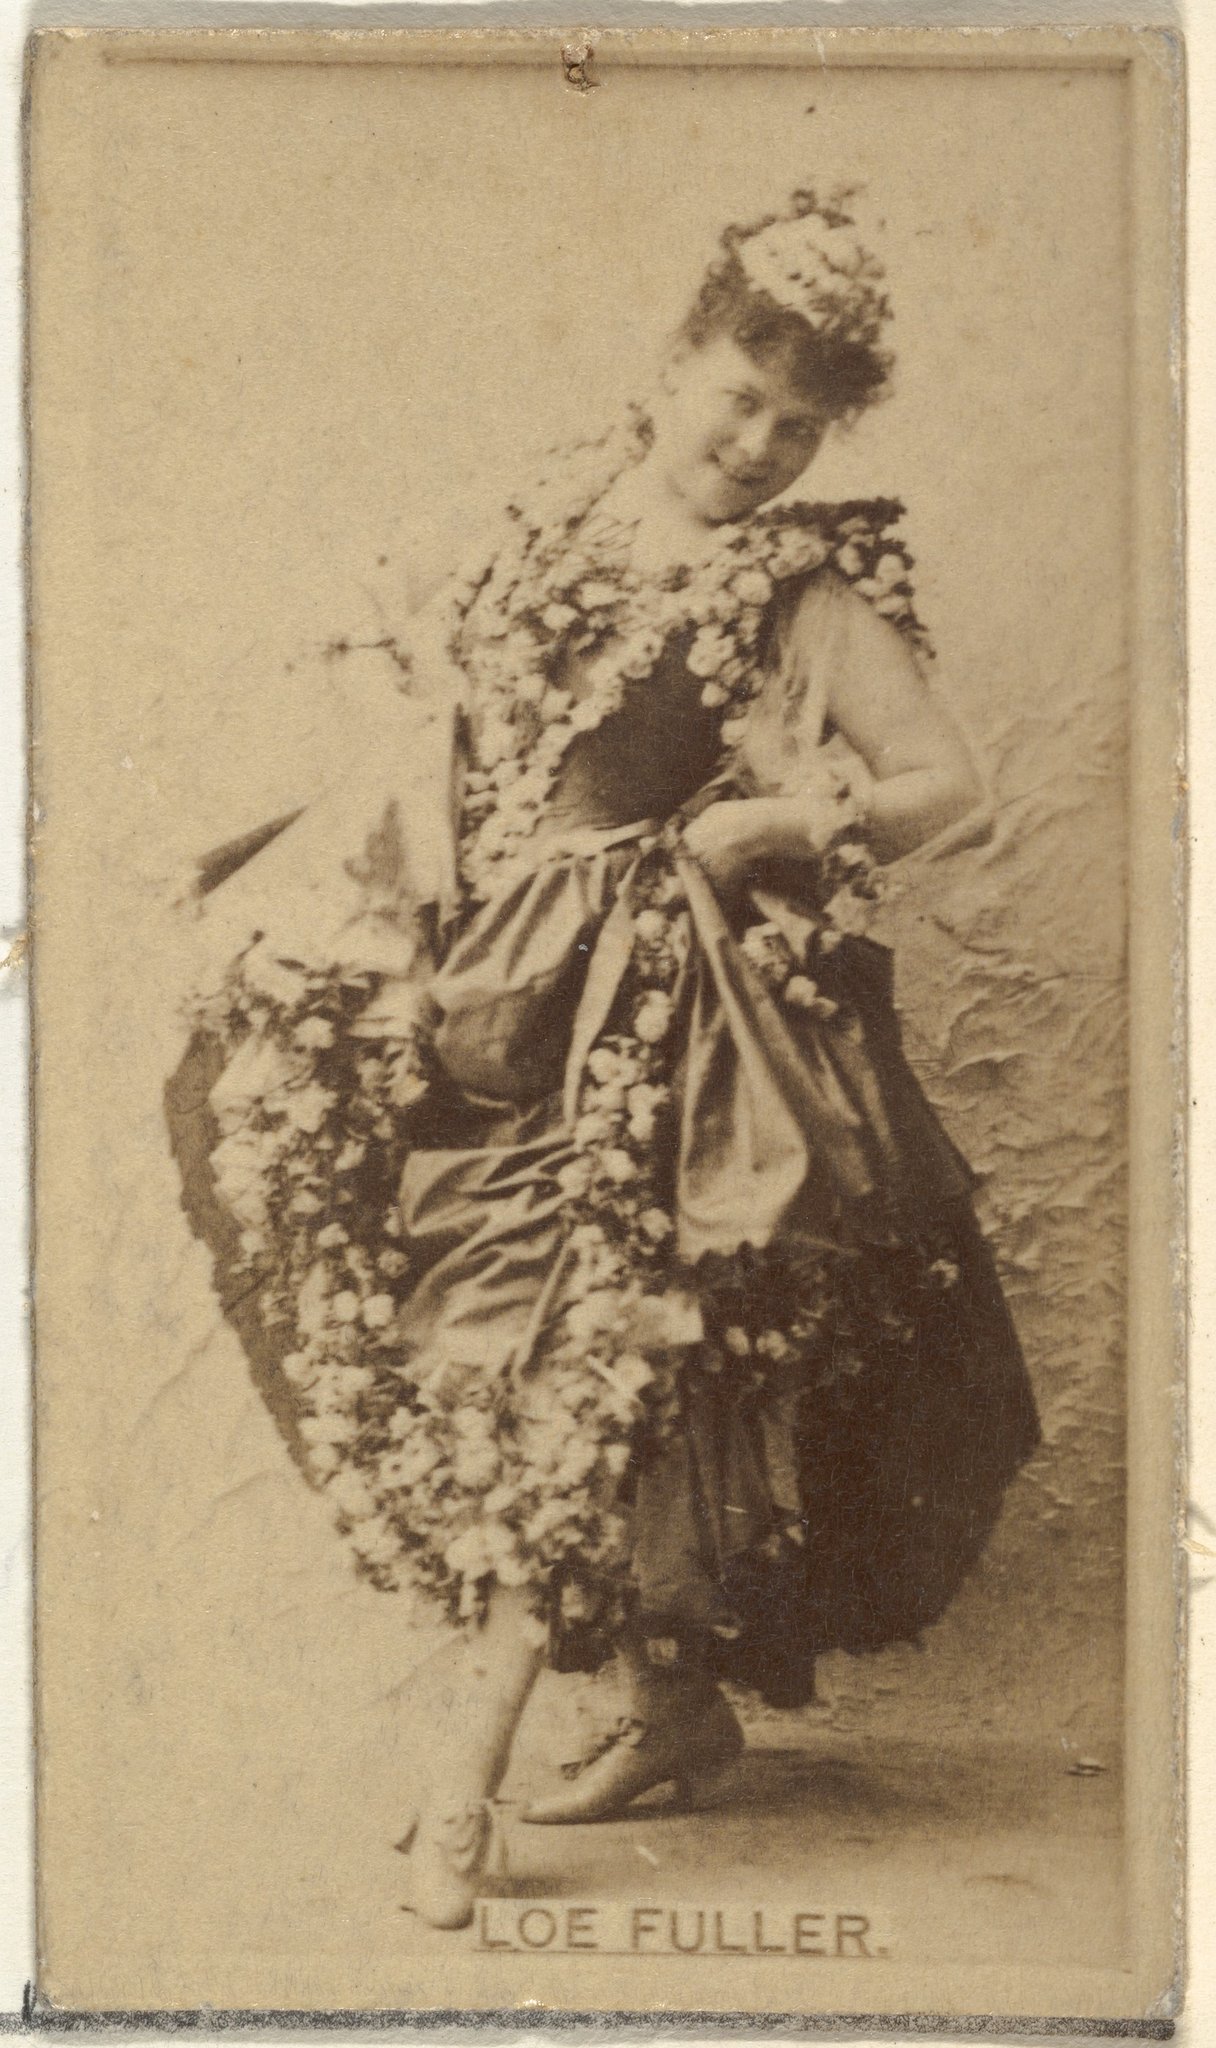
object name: photograph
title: Loe Fuller, from the Actors and Actresses series (N145-8) issued by Duke Sons & Co. to promote Duke Cigarettes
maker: w. duke, sons & co.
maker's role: publisher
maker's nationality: american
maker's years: 1870-1920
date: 1891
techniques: albumen silver print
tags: portraits,women,actresses